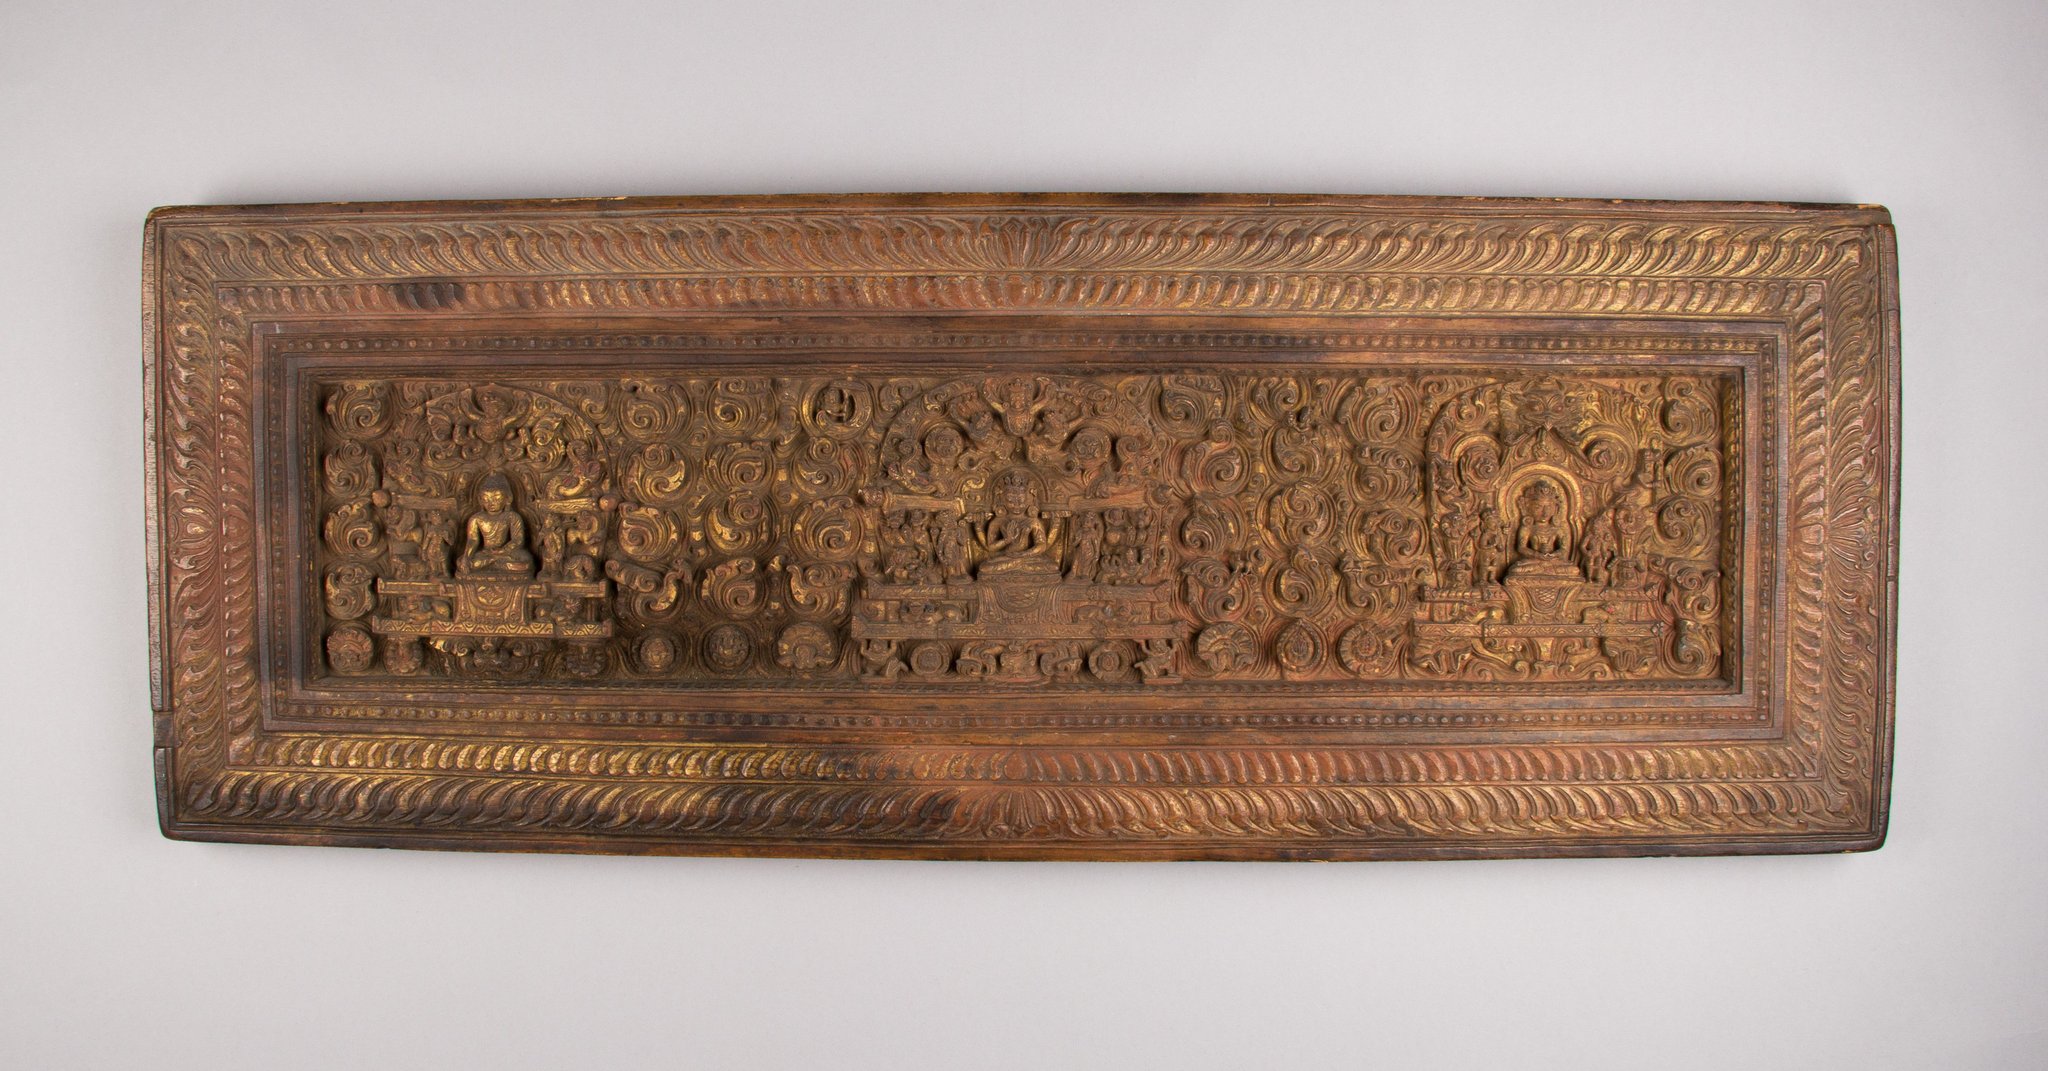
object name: panel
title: Central Panel or Book Cover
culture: tibetan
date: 1401-1600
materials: wood